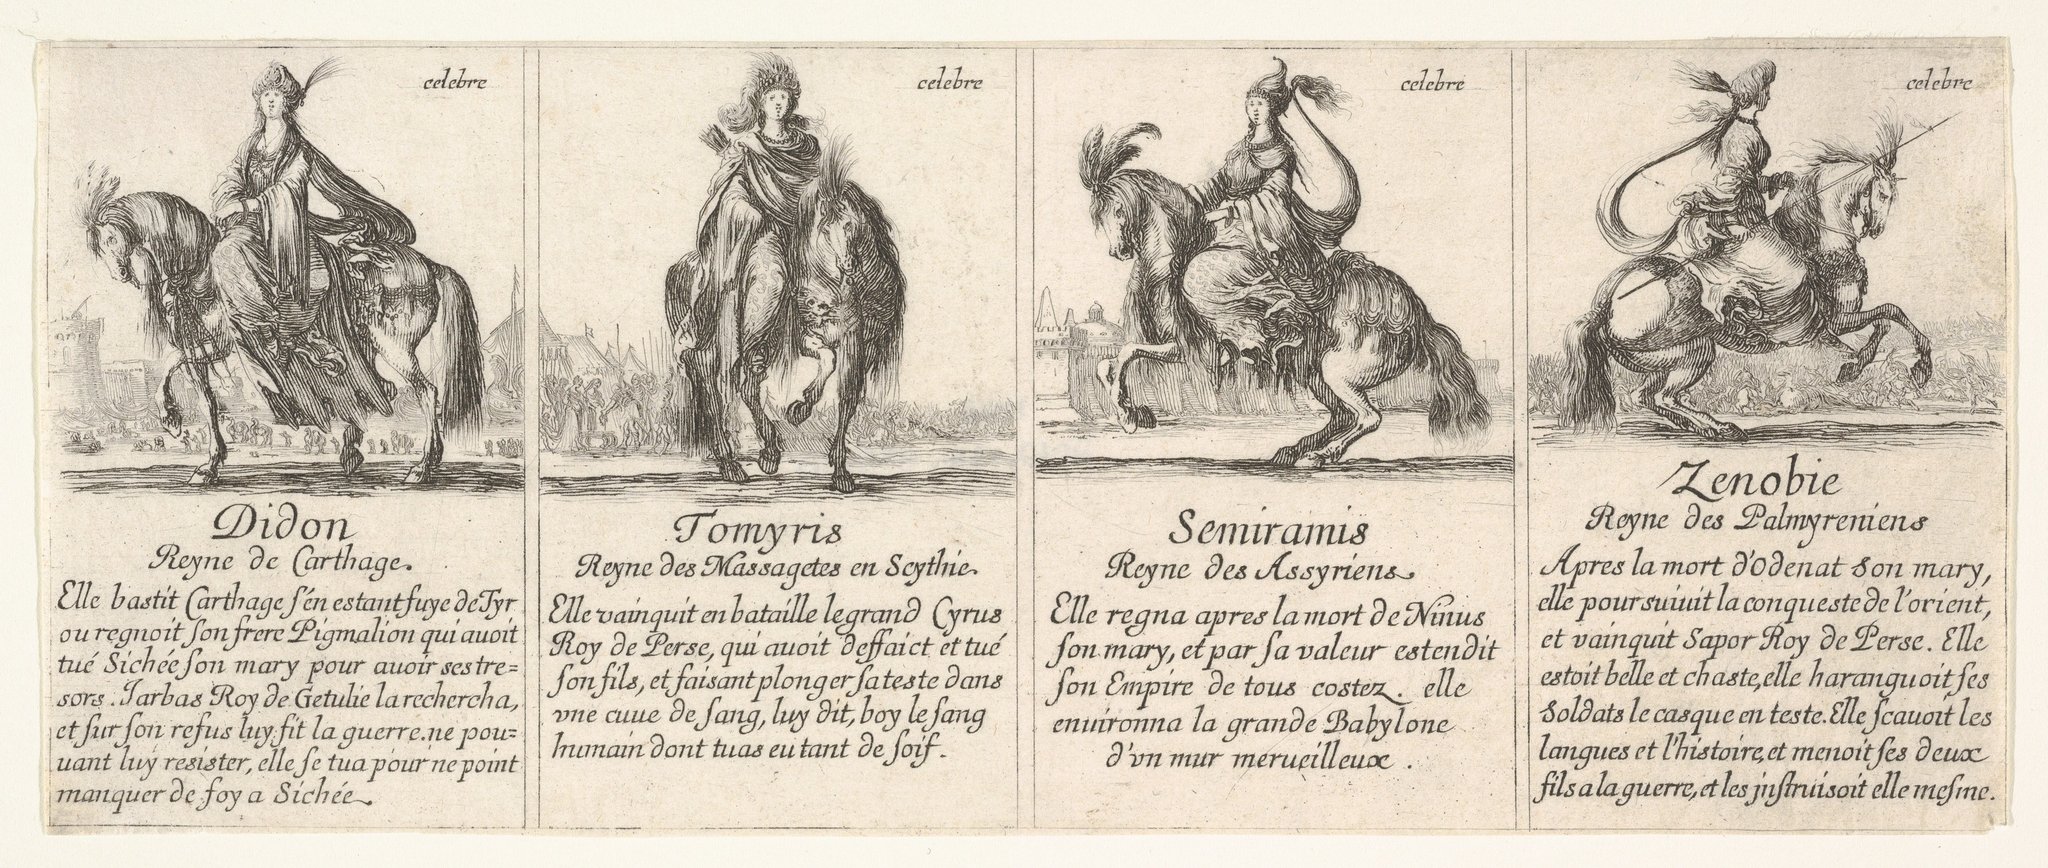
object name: print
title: Didon, Tomyris, Semiramis, and Zenobie, from "The Game of Queens" (Le Jeu des Reines Renommées)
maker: stefano della bella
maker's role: artist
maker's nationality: italian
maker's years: 1610-1664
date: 1644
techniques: etching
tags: women,horses